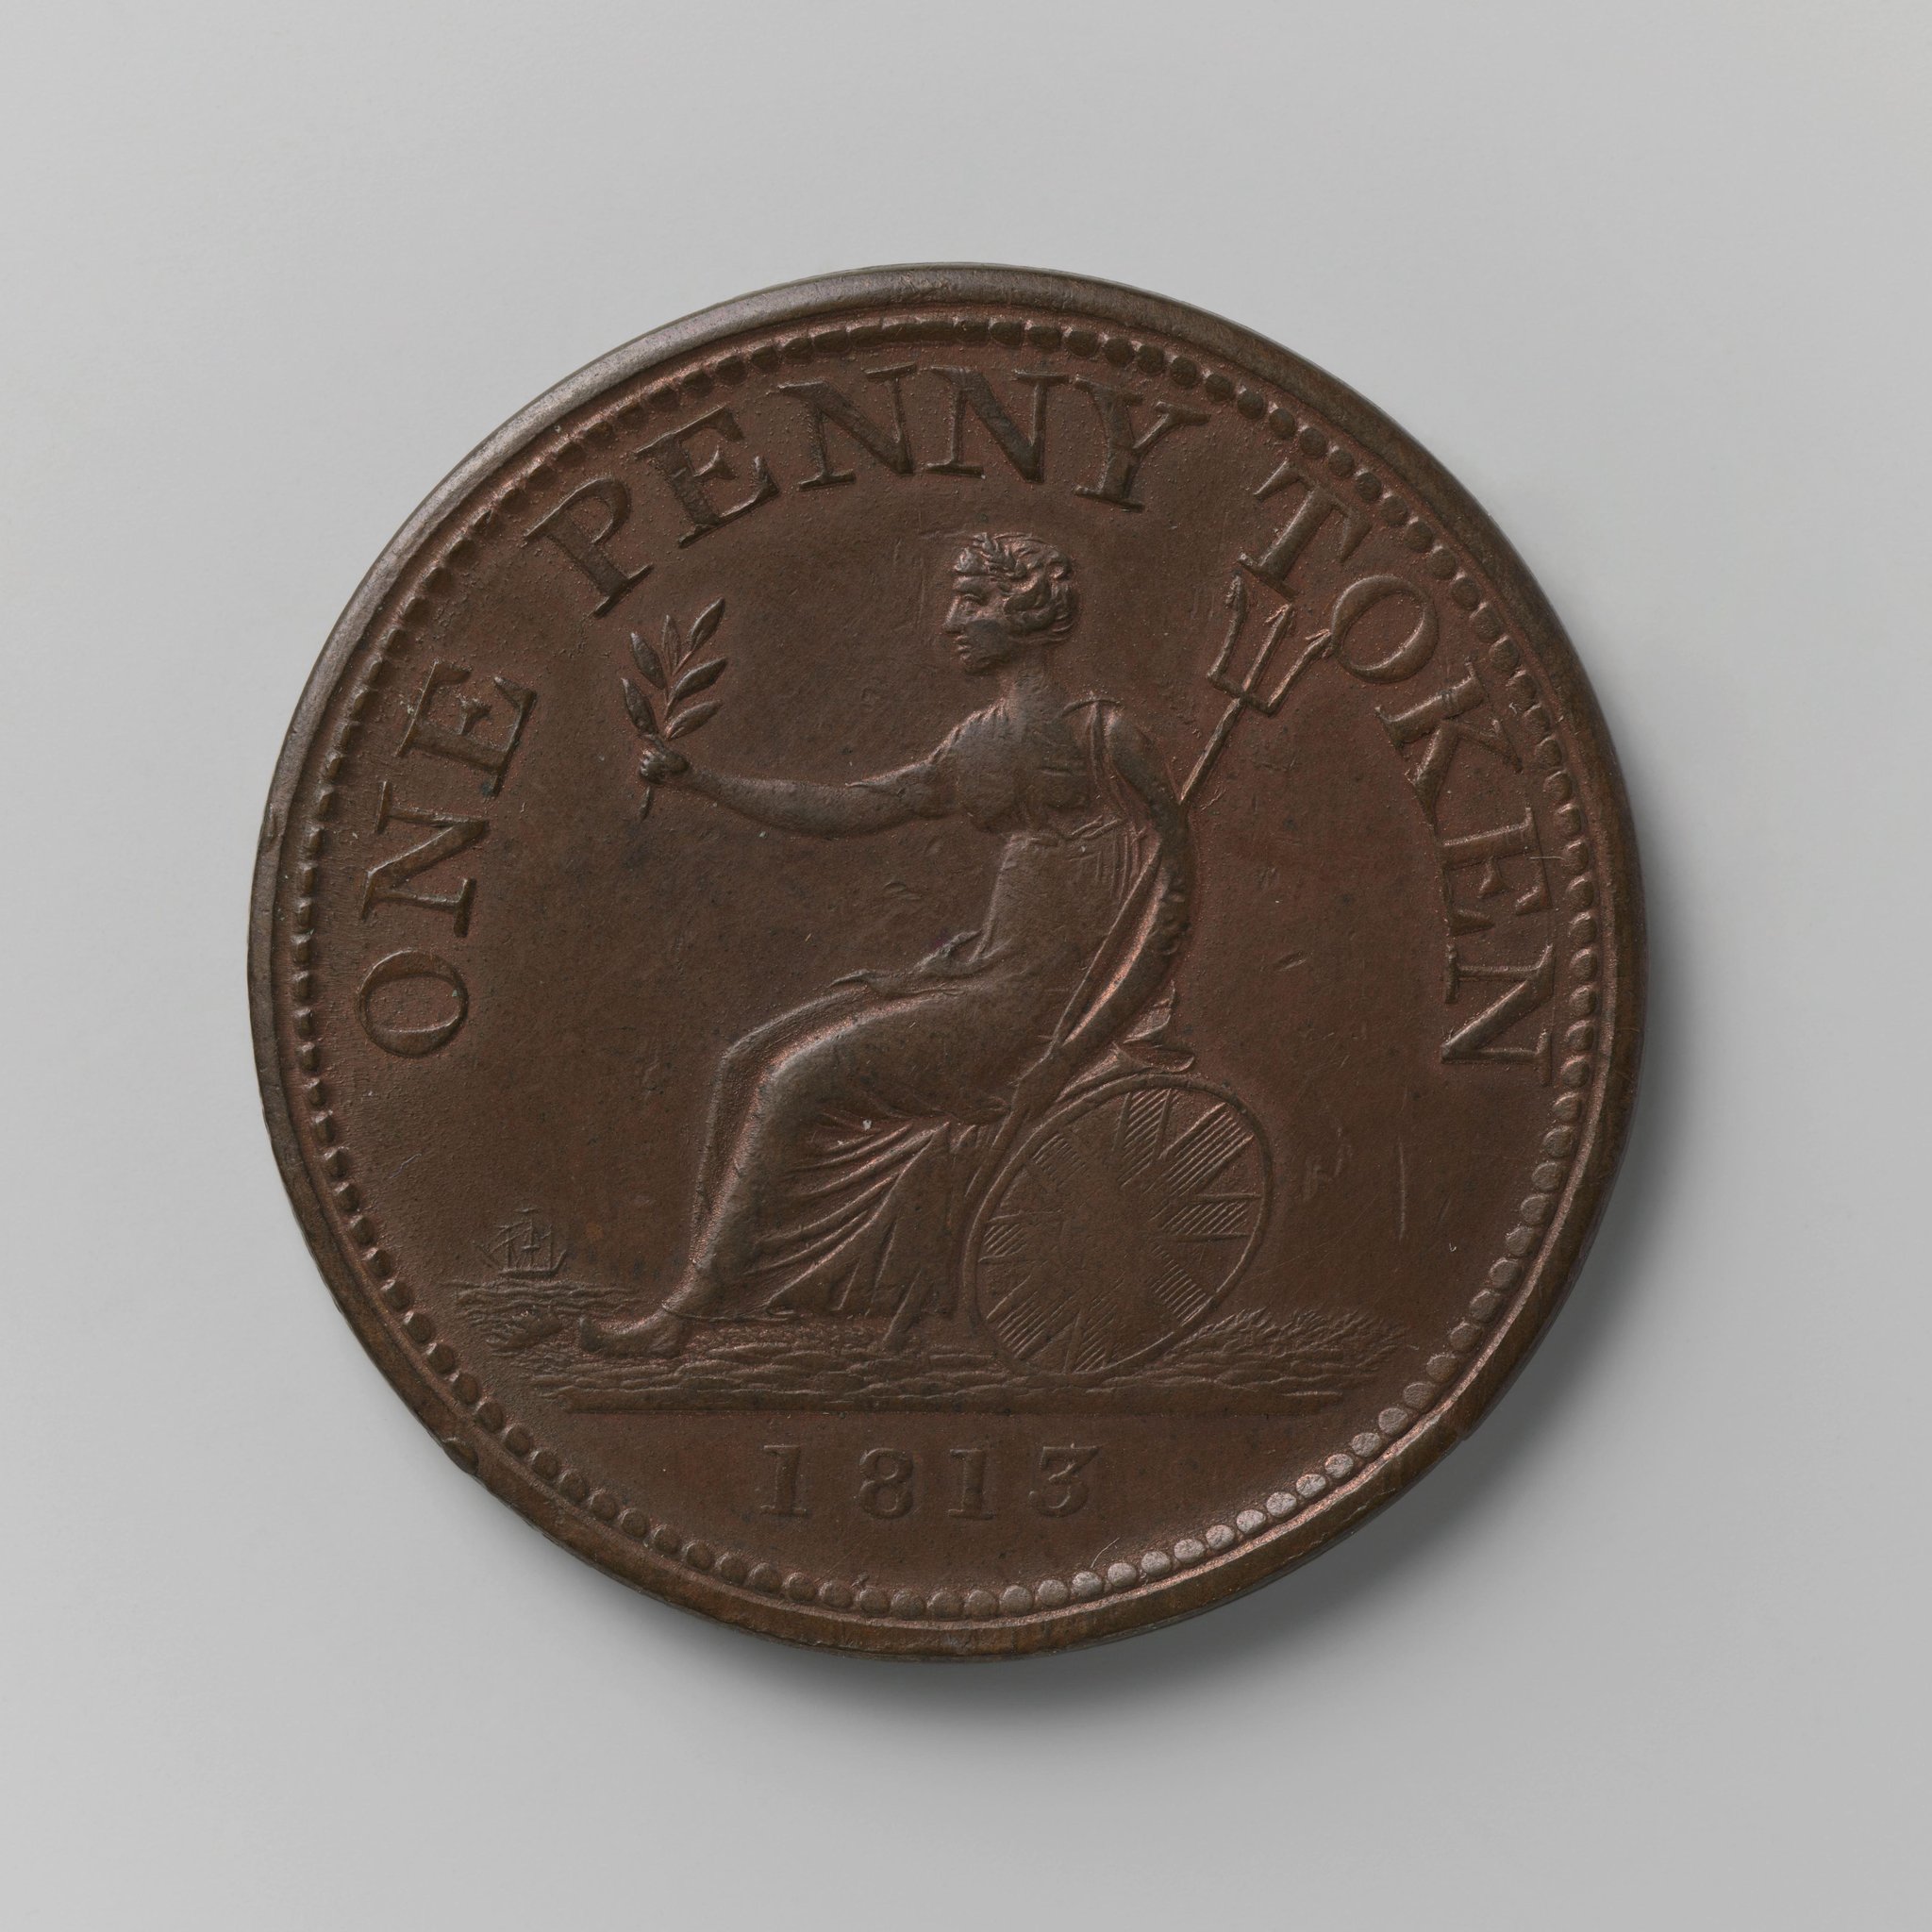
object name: monetary token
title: Penny-token, Engeland, 1813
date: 1813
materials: copper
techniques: striking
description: Koperen particuliere munt. Voorzijde: op schild gezeten Brittannnia met drietand en takken, naar links. Daarboven waarde-aanduiding. In afsnede jaartal. Keerzijde: borstbeeld van een man [Welllington] naar links. Kabelrand.